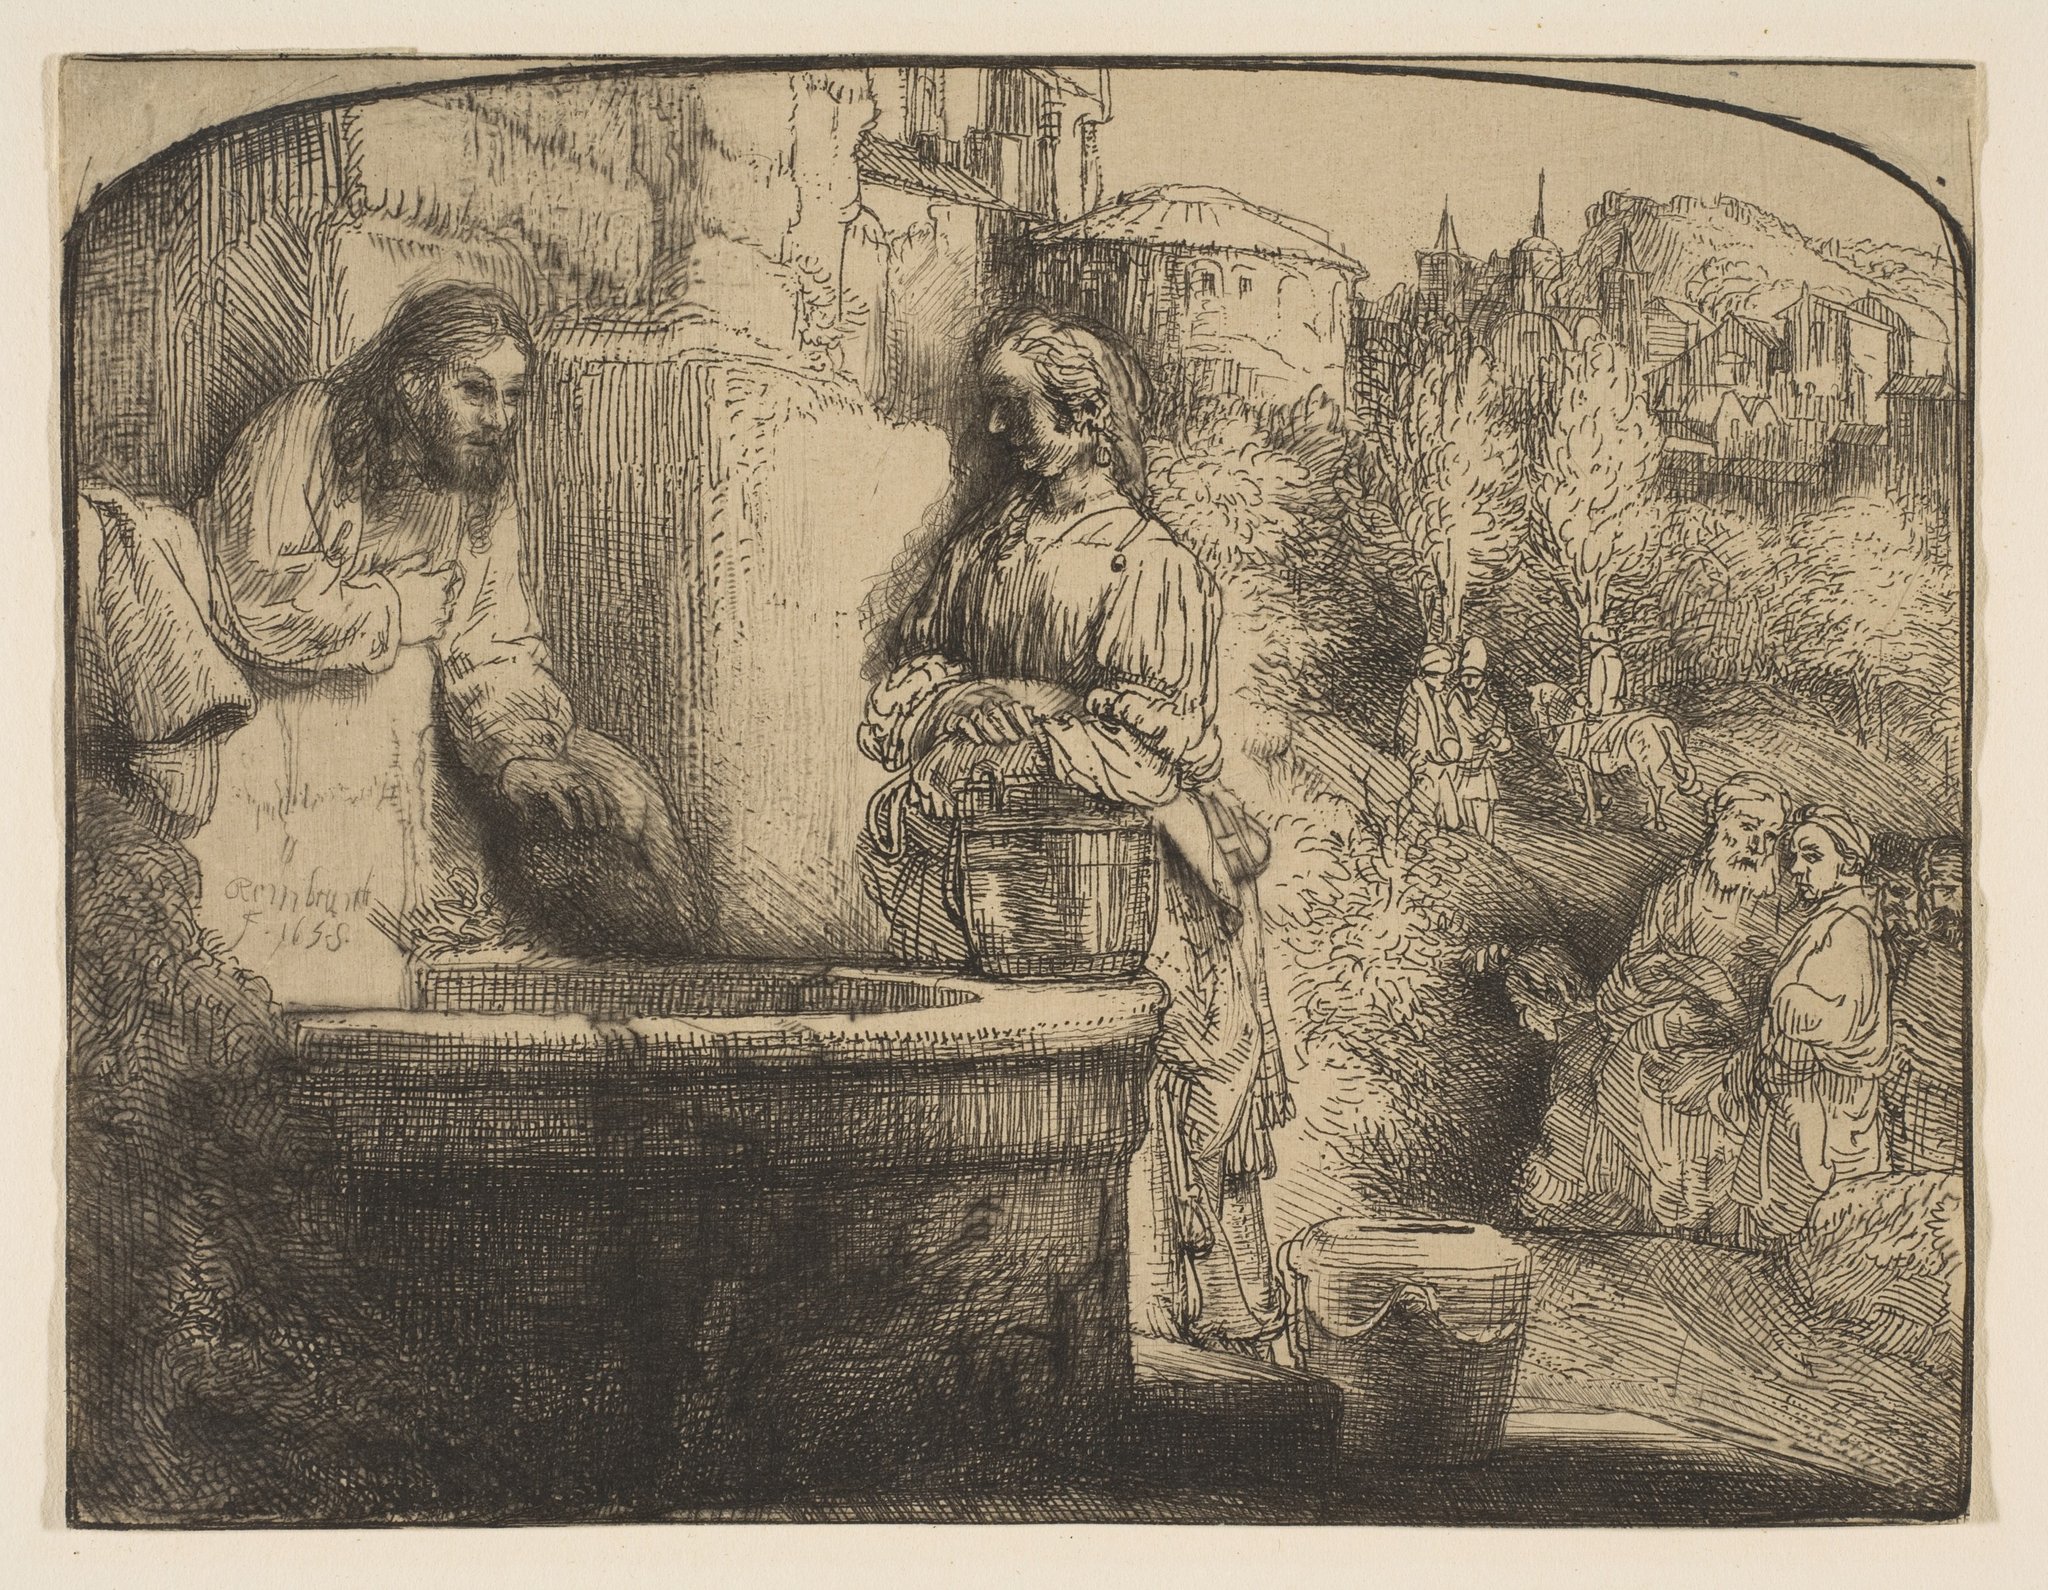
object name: print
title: Christ and the Woman of Samaria: an Arched Print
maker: rembrandt van rijn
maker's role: artist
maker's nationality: dutch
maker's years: 1606-1669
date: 1658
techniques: drypoint, etching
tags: men,women,jesus